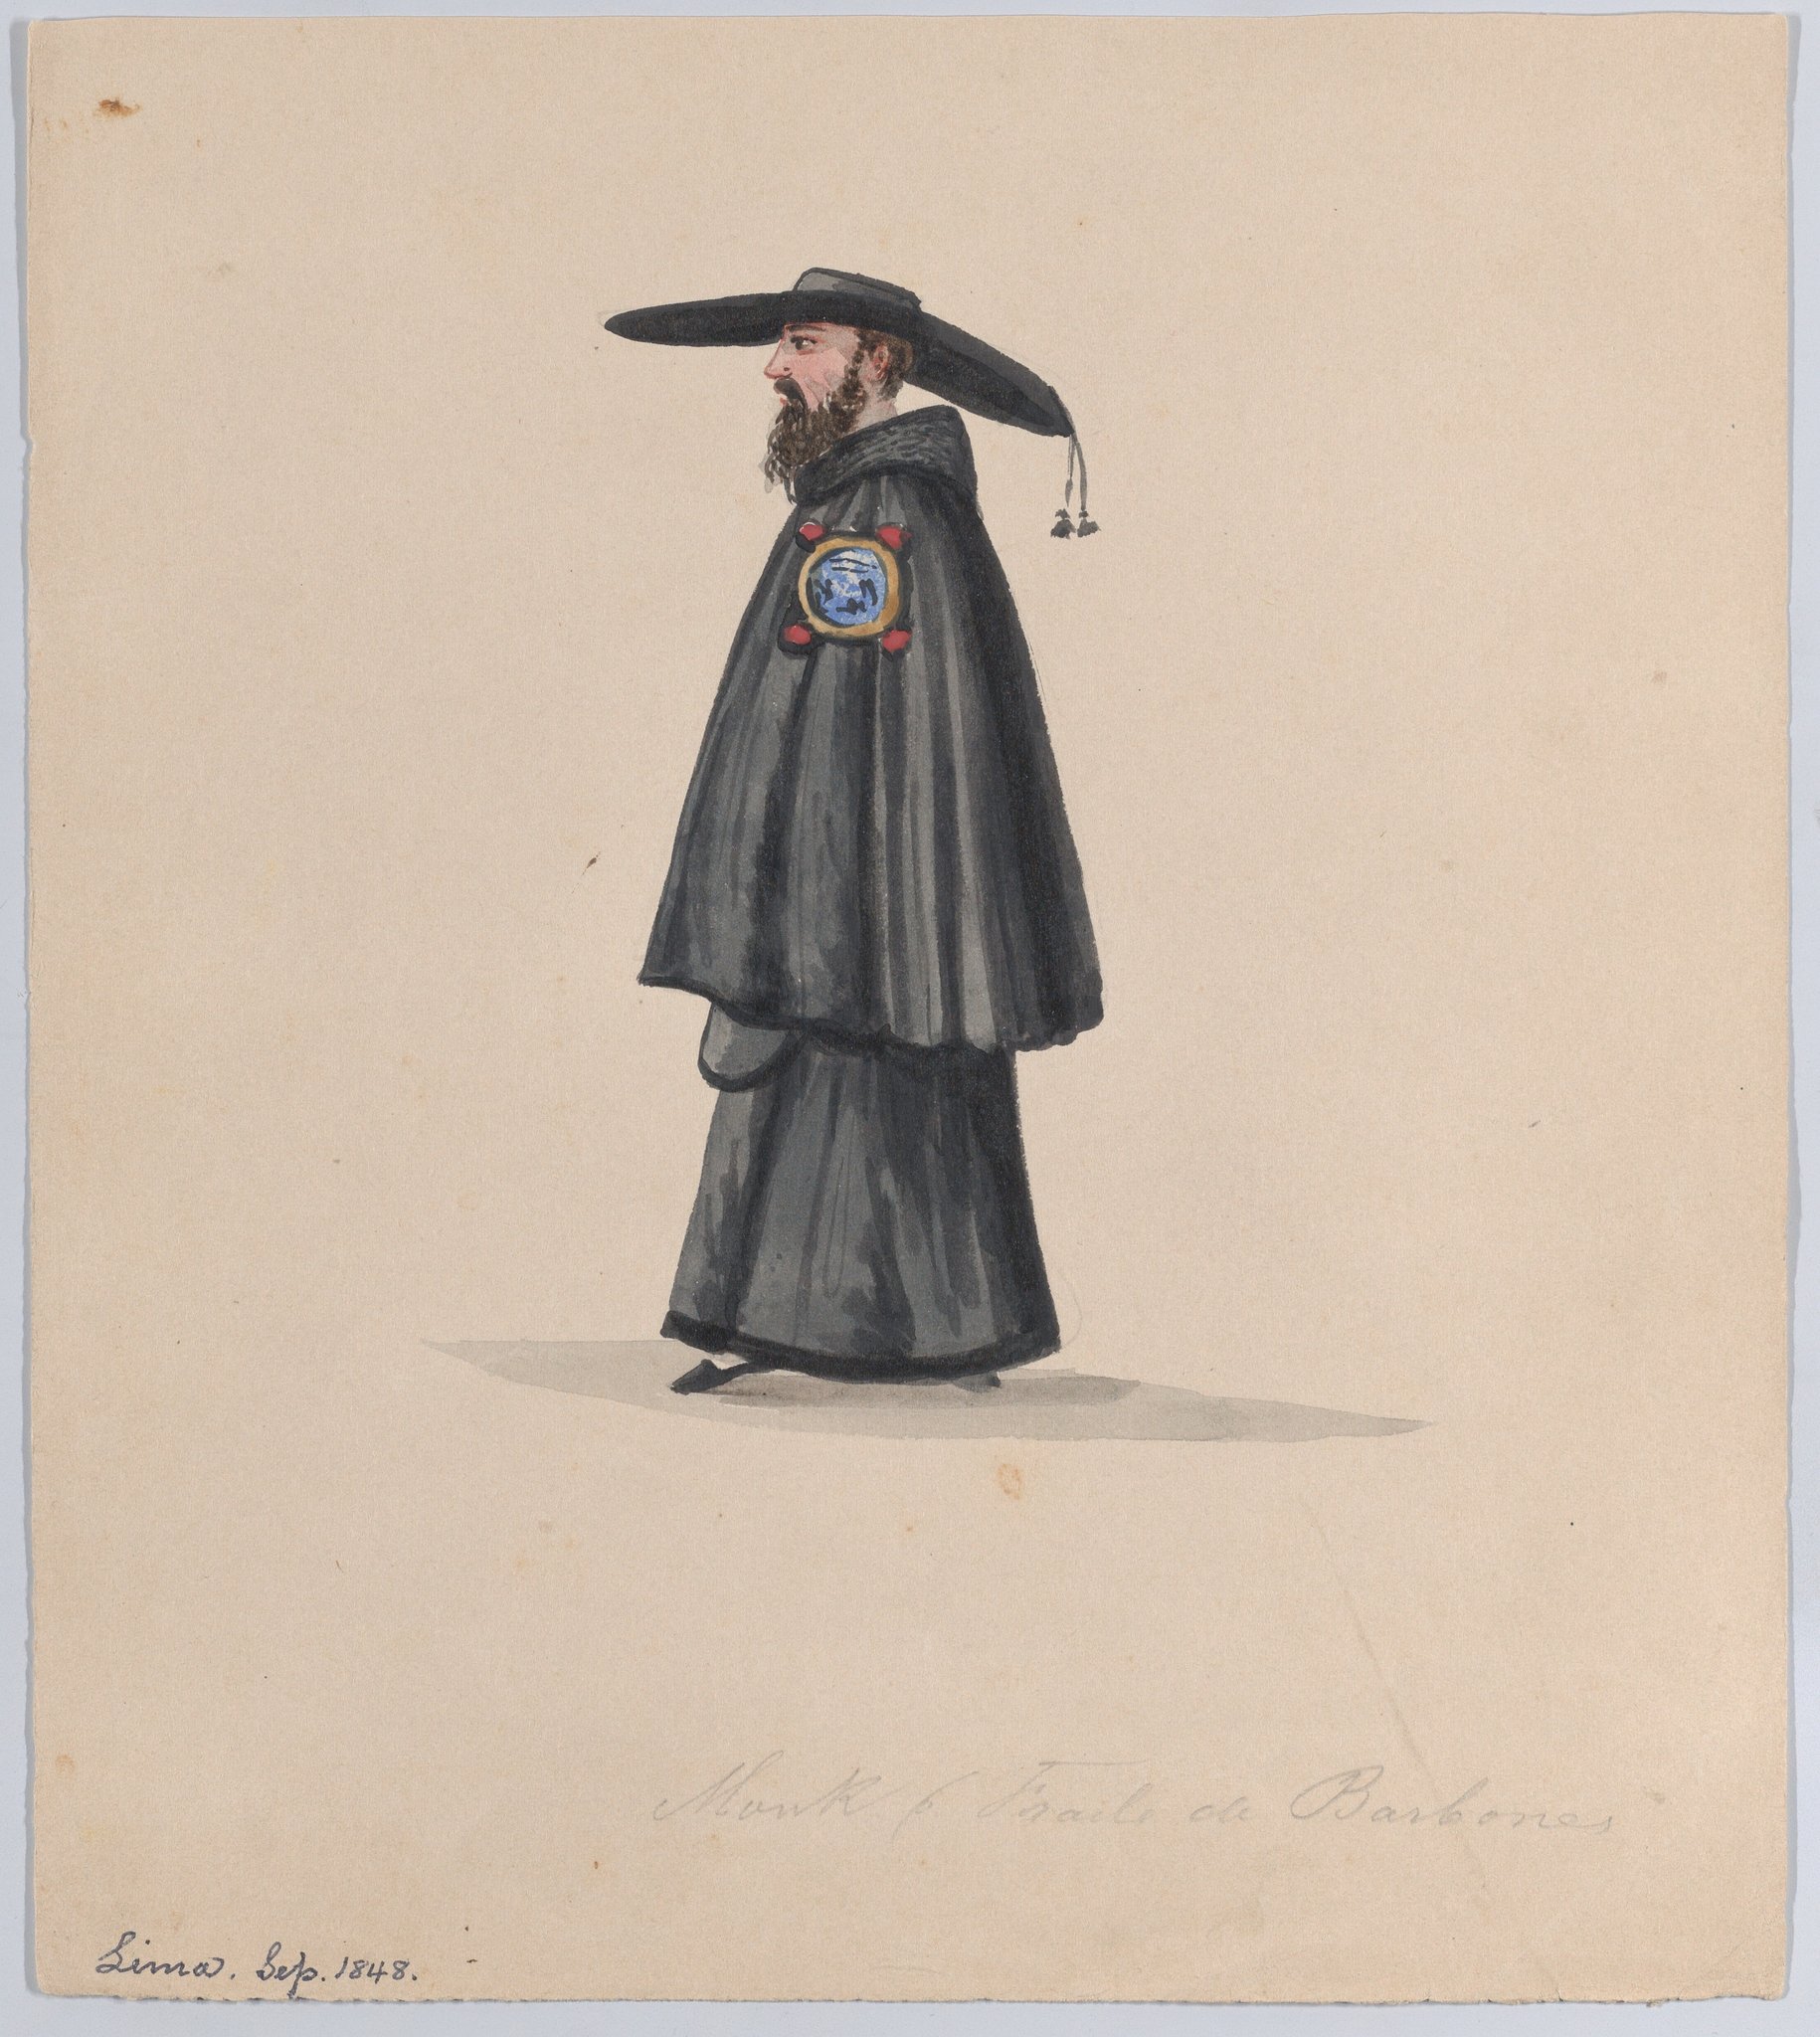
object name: drawing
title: A monk from the order of Barbones, from a group of drawings depicting Peruvian dress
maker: francisco (pancho) fierro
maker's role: artist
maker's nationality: african peruvian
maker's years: 1807-1879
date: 1848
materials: watercolor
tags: men,monks